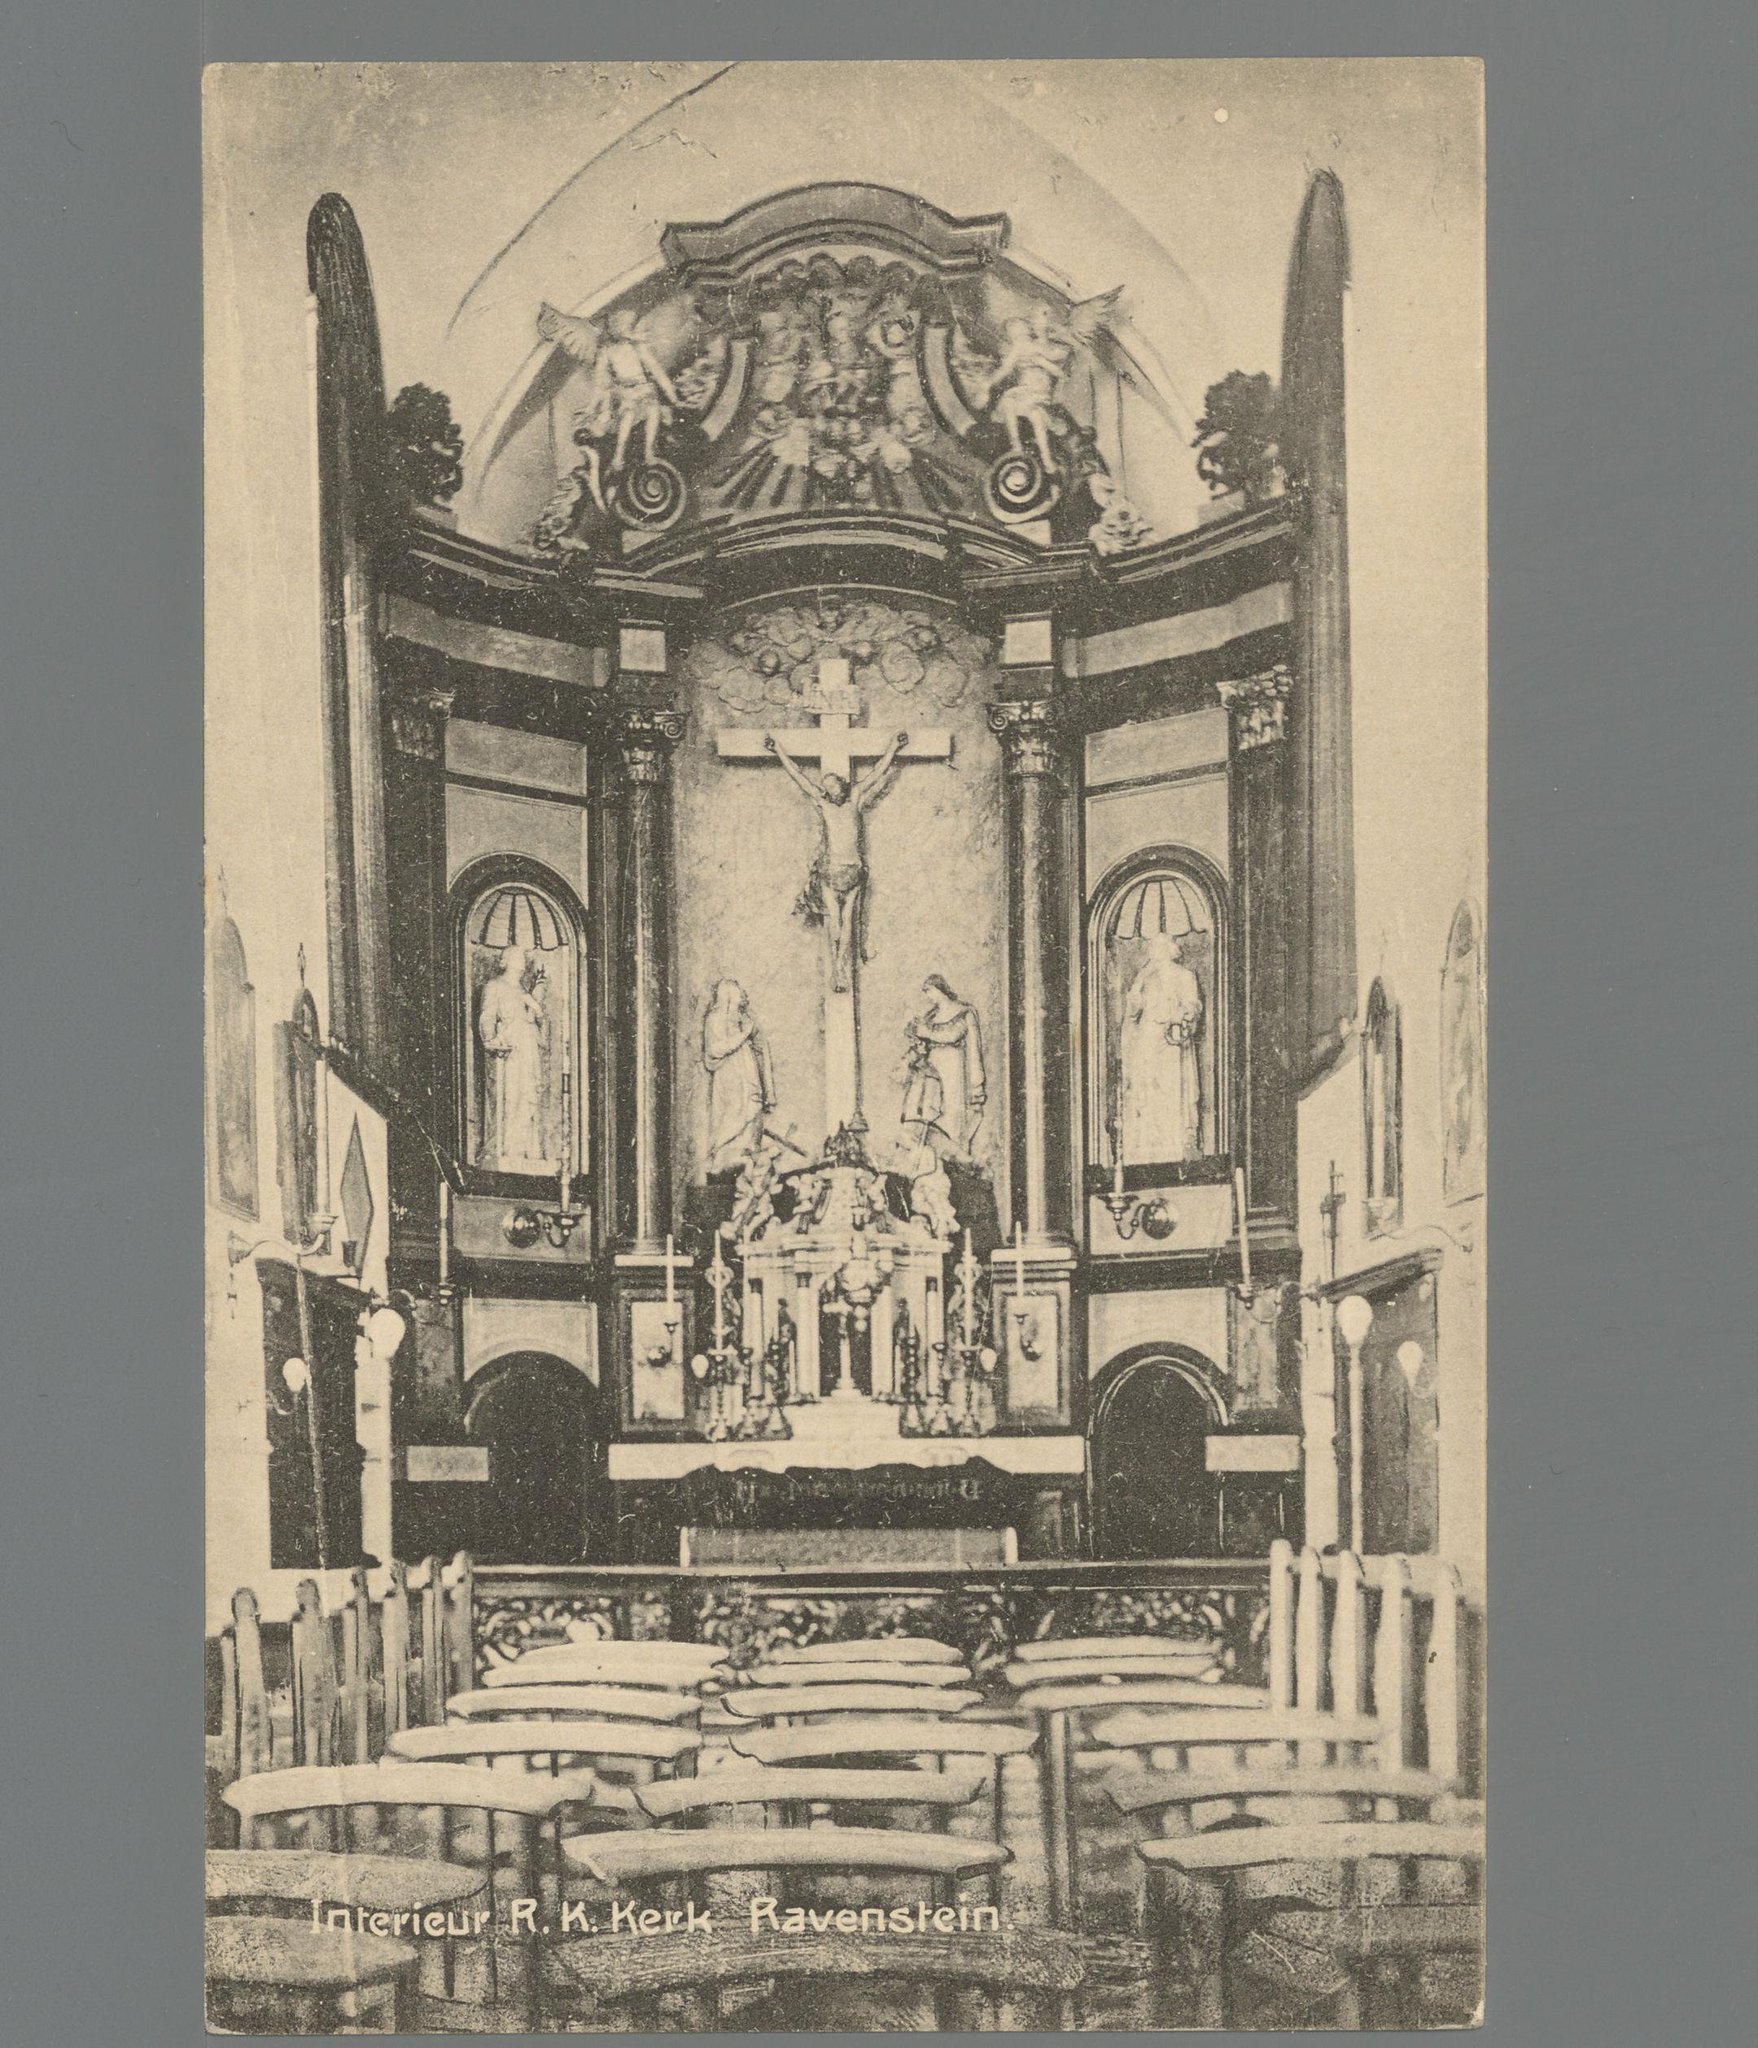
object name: ansichtkaart, prentbriefkaart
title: Interieur R.K. Kerk Ravenstein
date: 1909-1930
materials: cardboard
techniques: photograph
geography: ravenstein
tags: interior of church